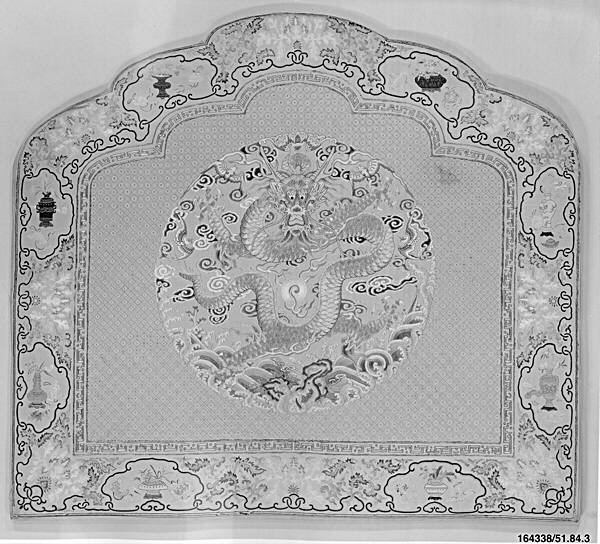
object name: cushion cover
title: Cushion Cover for Throne Back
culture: chinese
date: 1723-1735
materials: metal thread, silk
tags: dragons